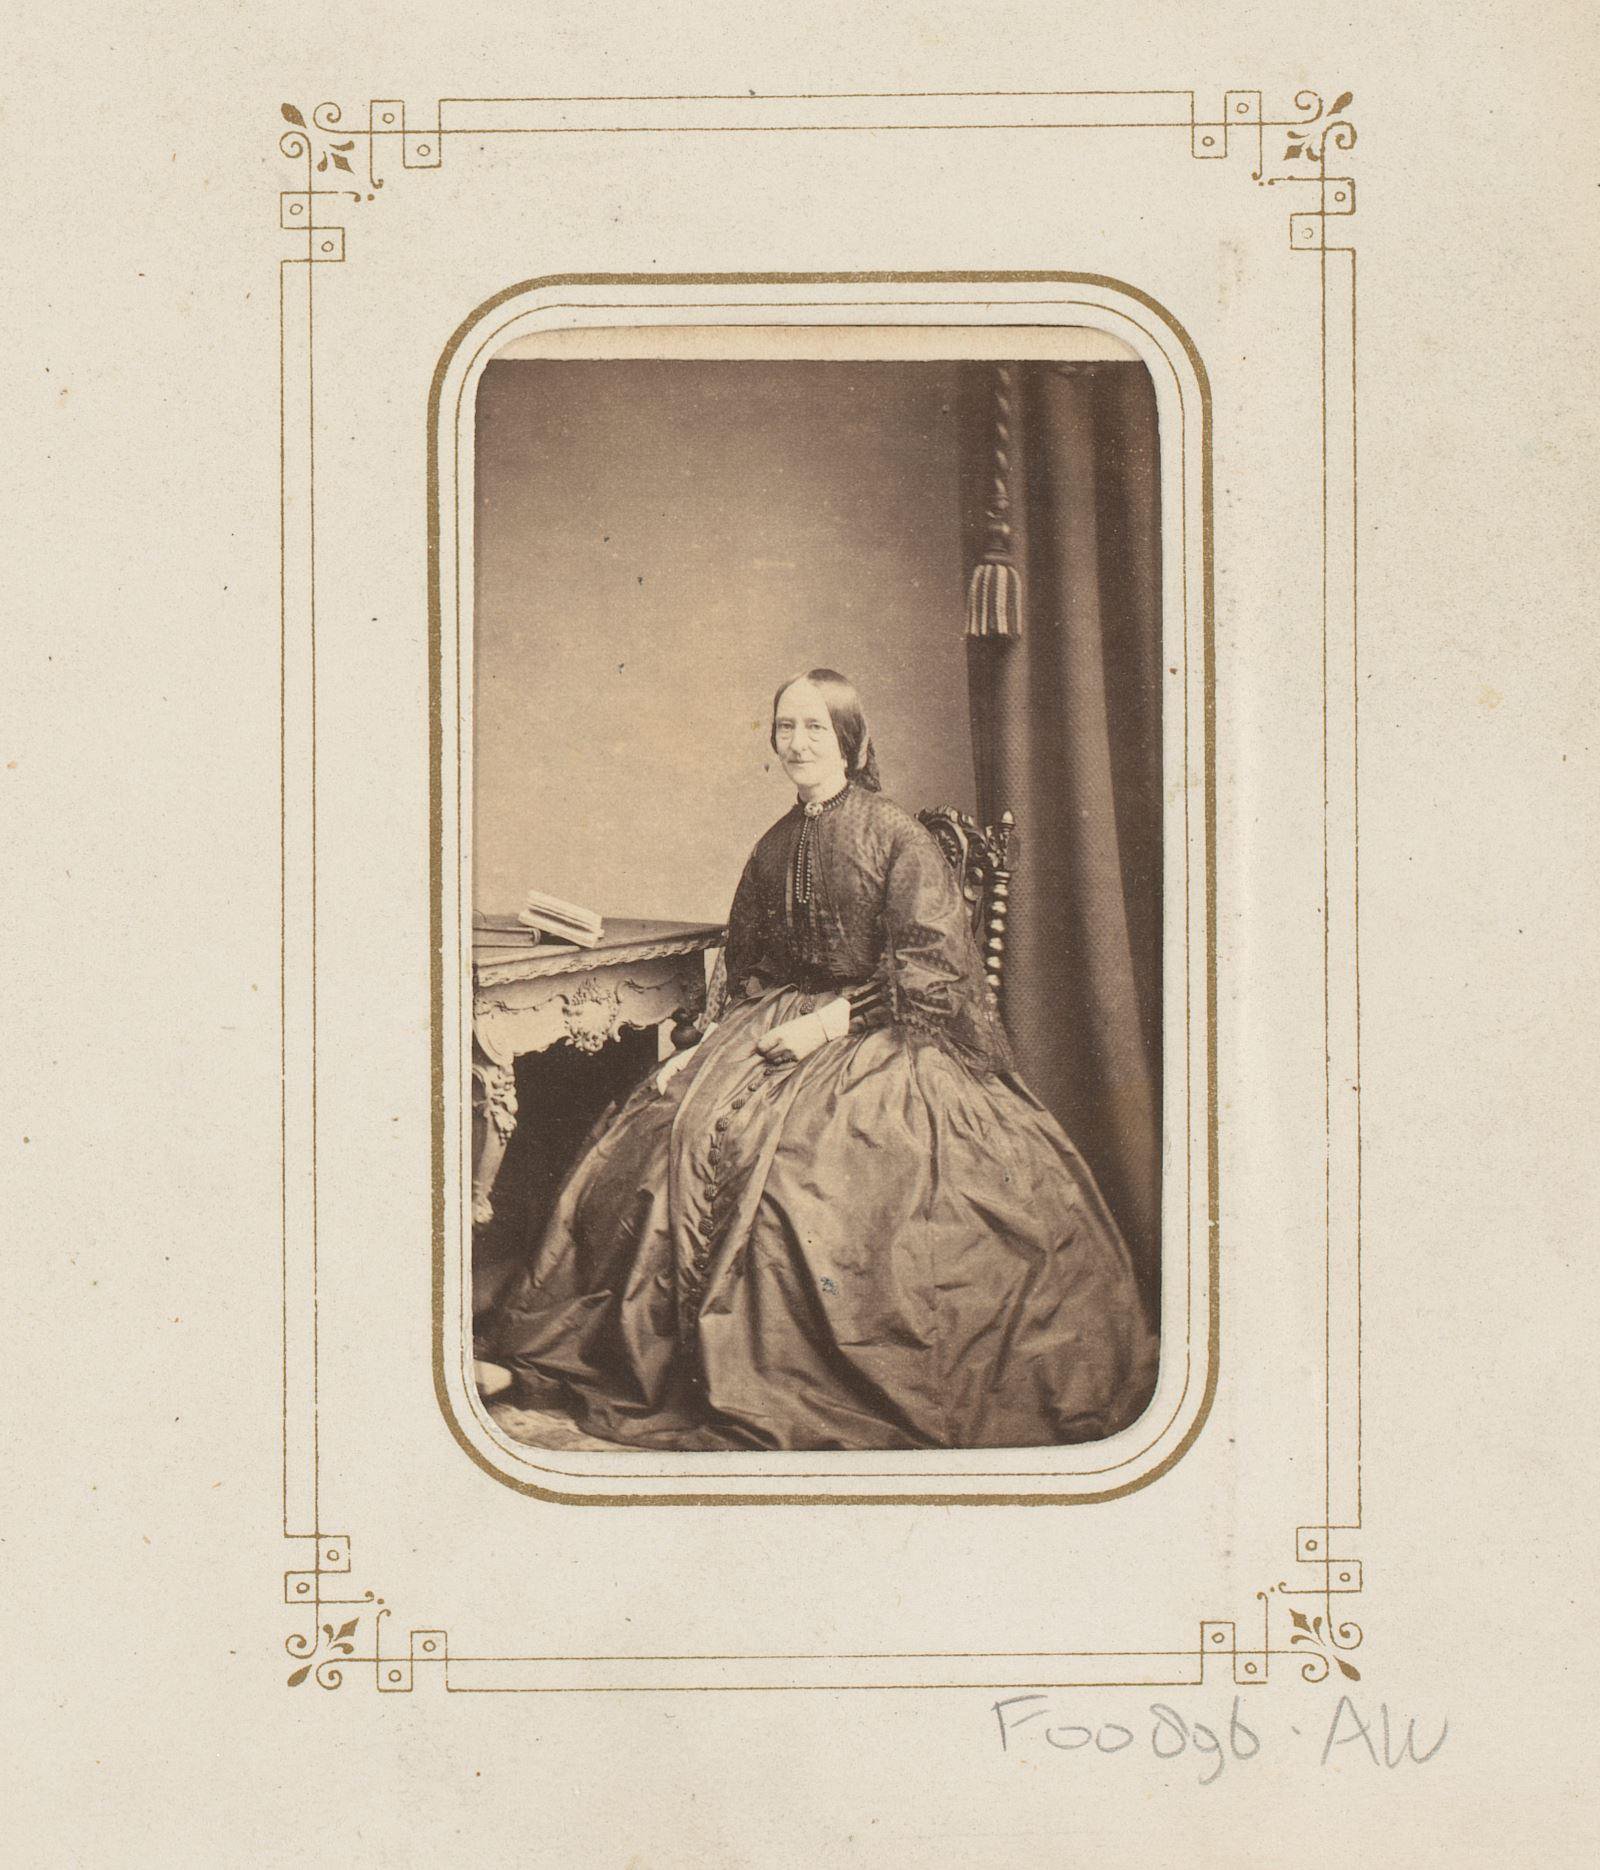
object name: photograph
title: Portret van een vrouw, zittend aan een tafel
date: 1855-1865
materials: cardboard, photographic support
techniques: albumen print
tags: sitting figure - aa - female human figure, historical persons, book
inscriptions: number: ‘35311’, inscription: ‘The London School of Photography/ 103, Newgate Street/ 174, Regent Street’